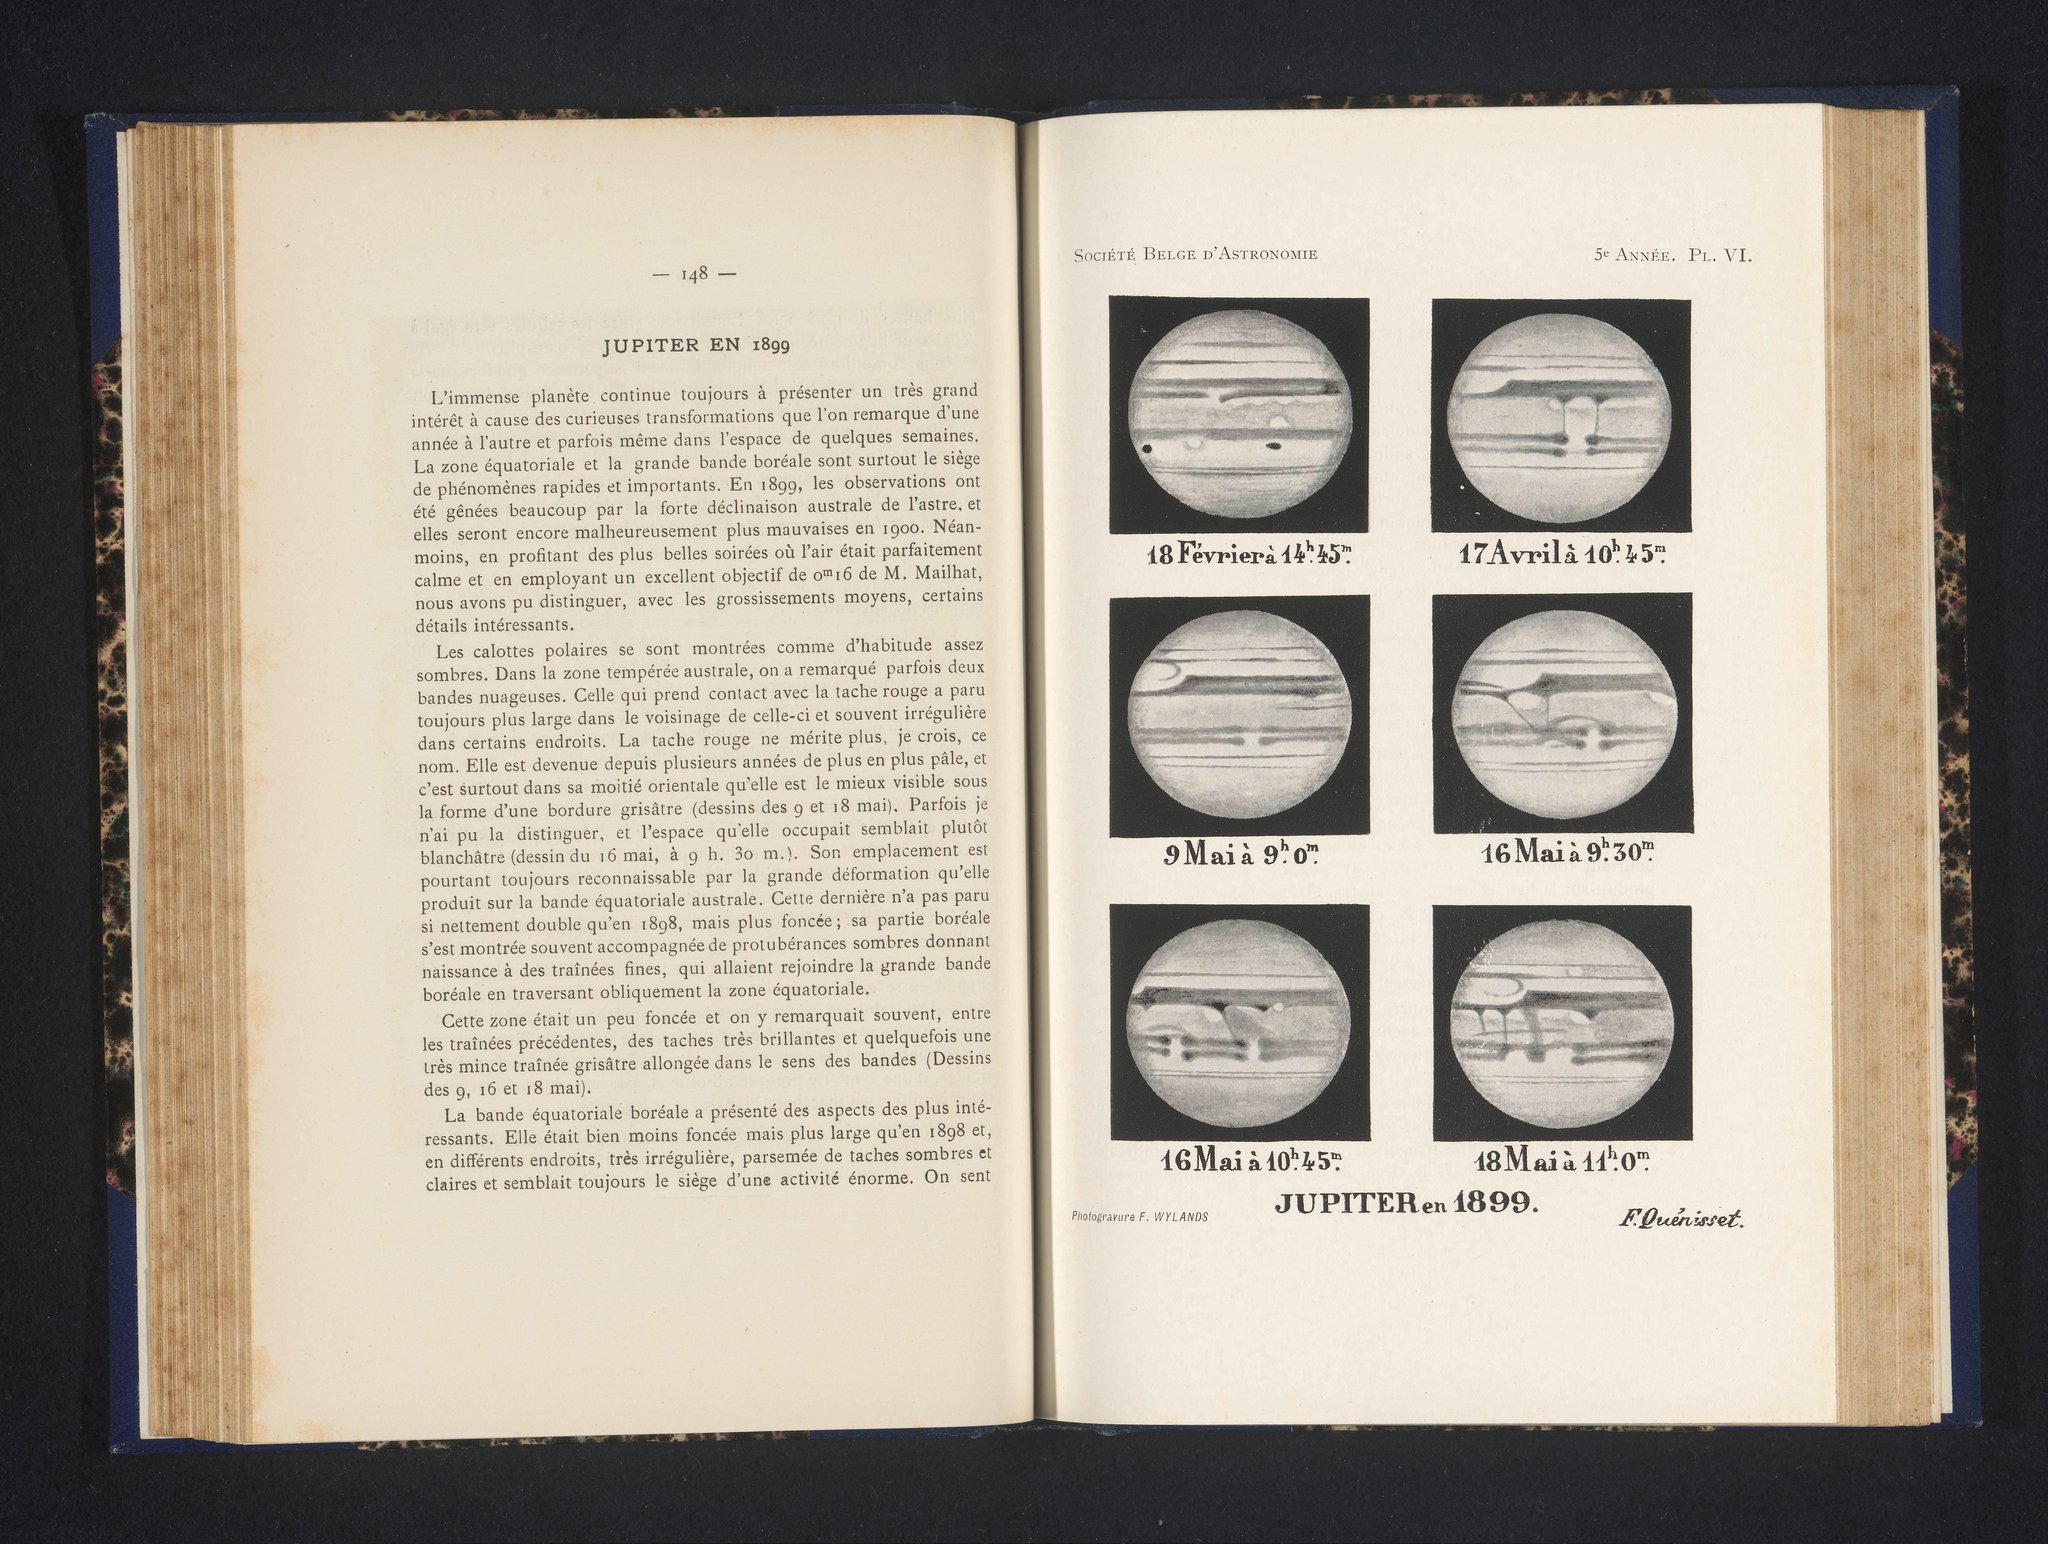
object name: photomechanical print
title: Jupiter en 1899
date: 1899-1900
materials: paper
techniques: autotype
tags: jupiter (planet)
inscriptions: inscription: ‘5e année. Pl. VI.’